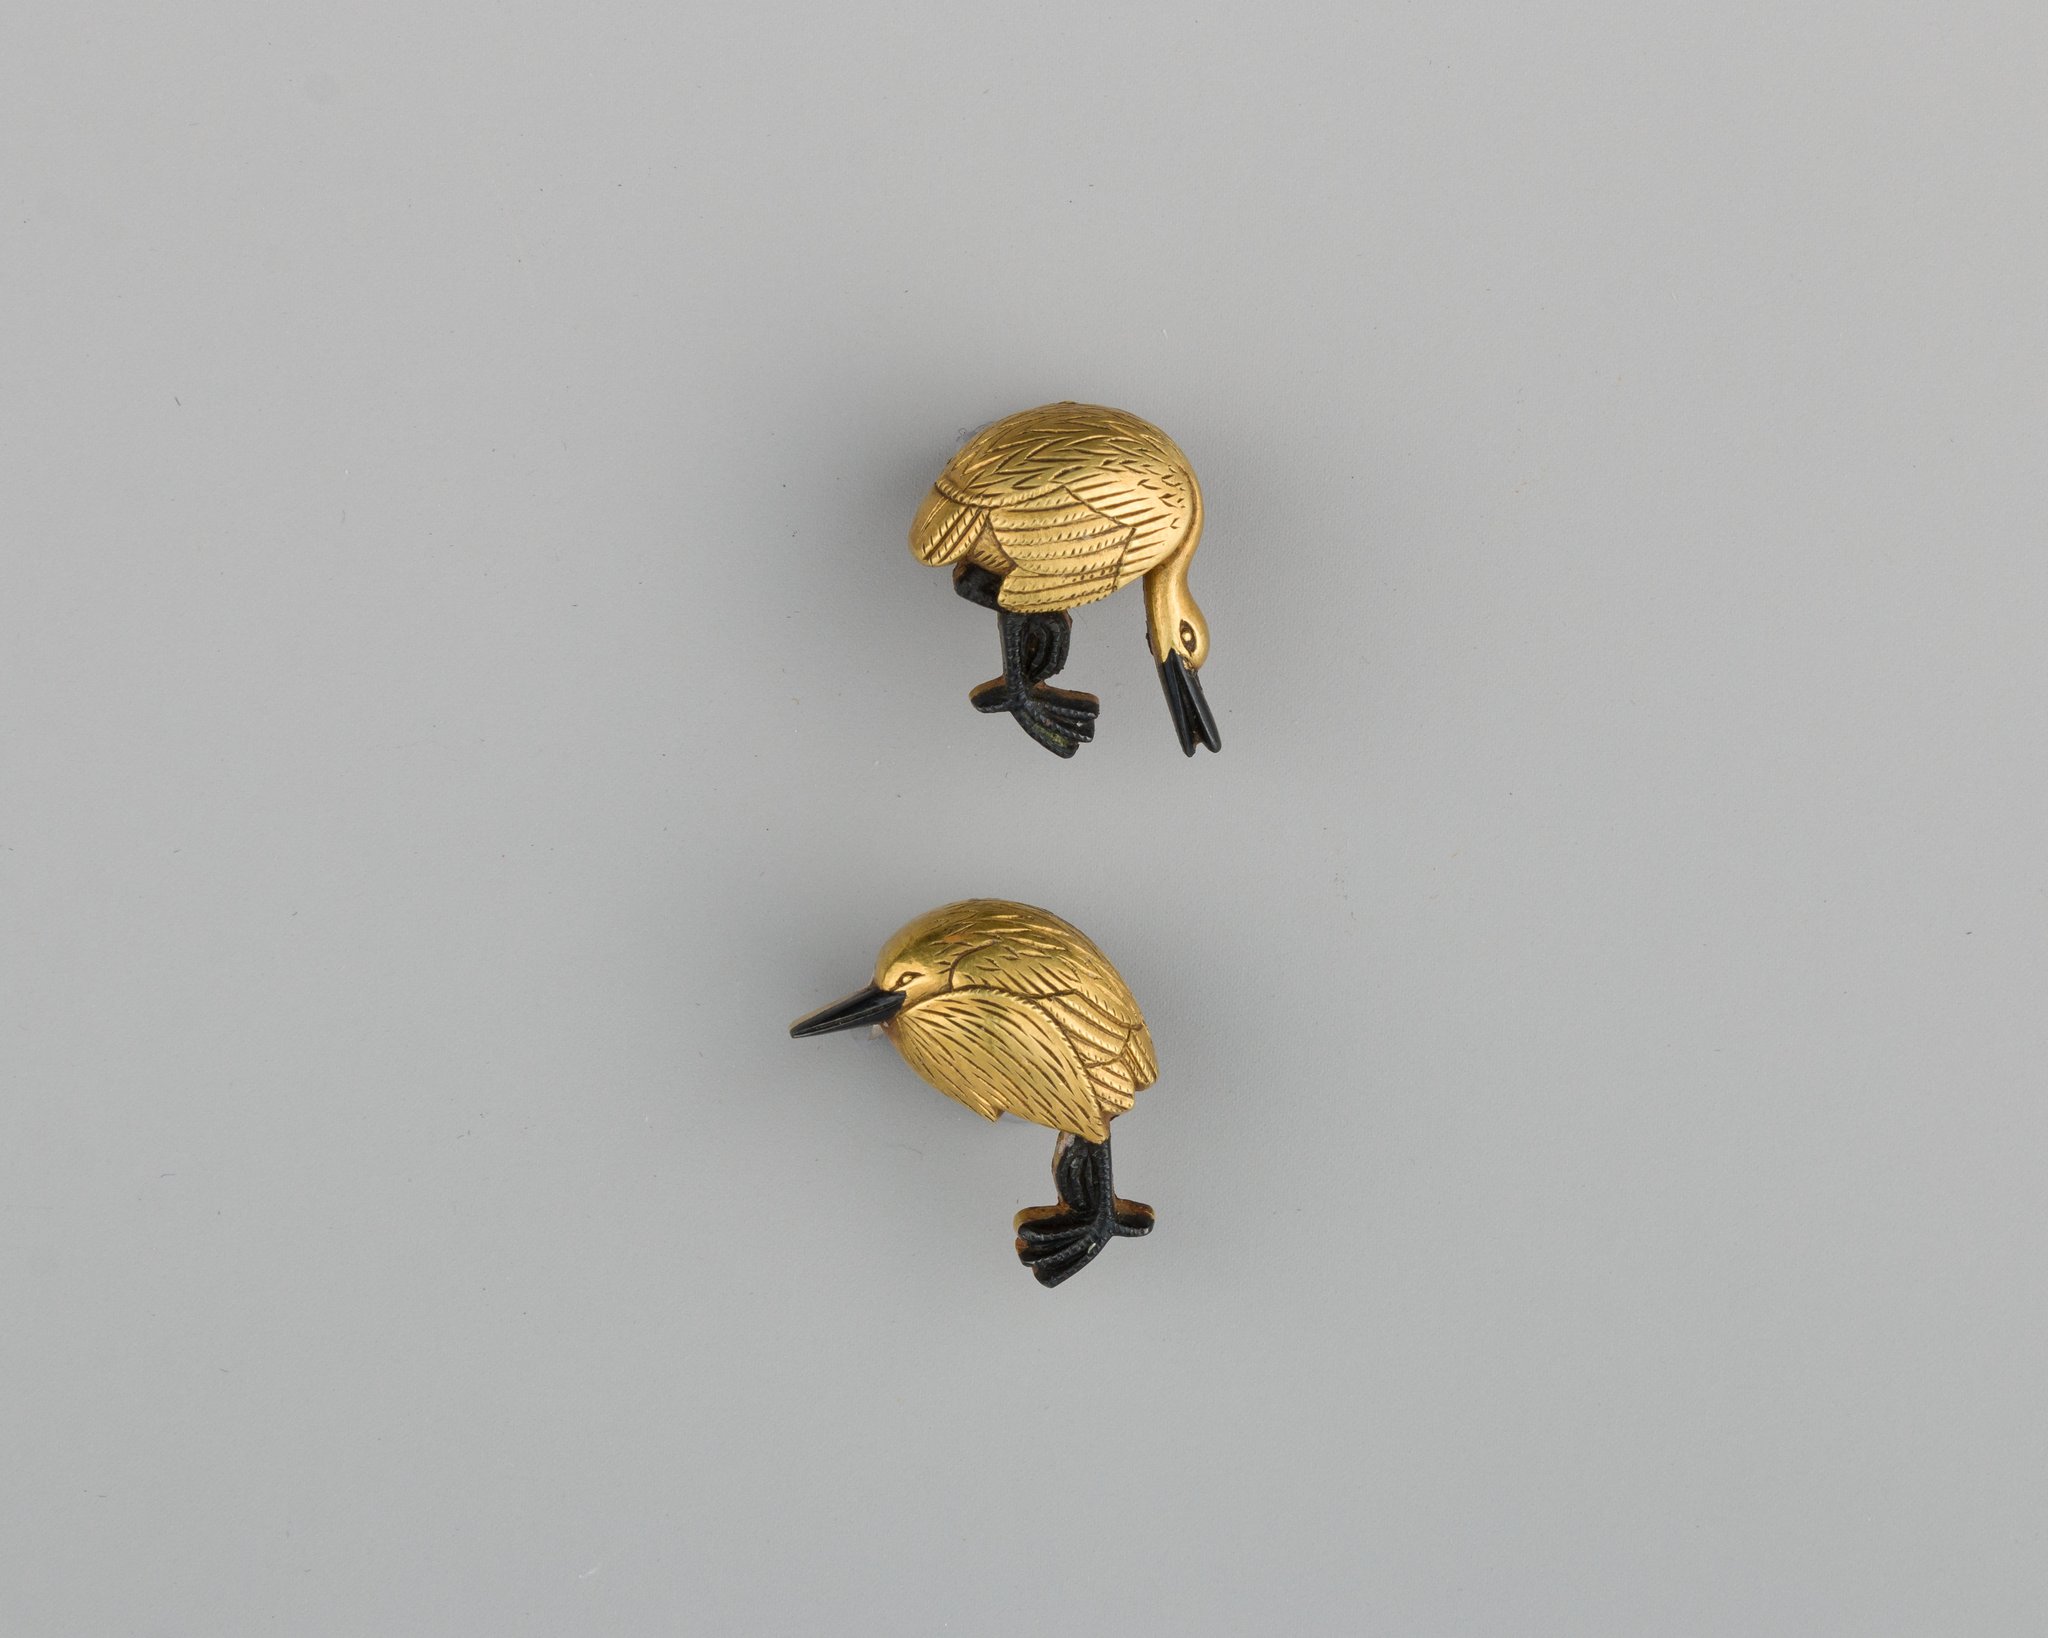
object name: pair of sword grip ornament menuki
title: Pair of Sword-Grip Ornaments (Menuki)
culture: japanese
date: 1701-1800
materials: gold alloy, gold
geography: japan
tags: birds